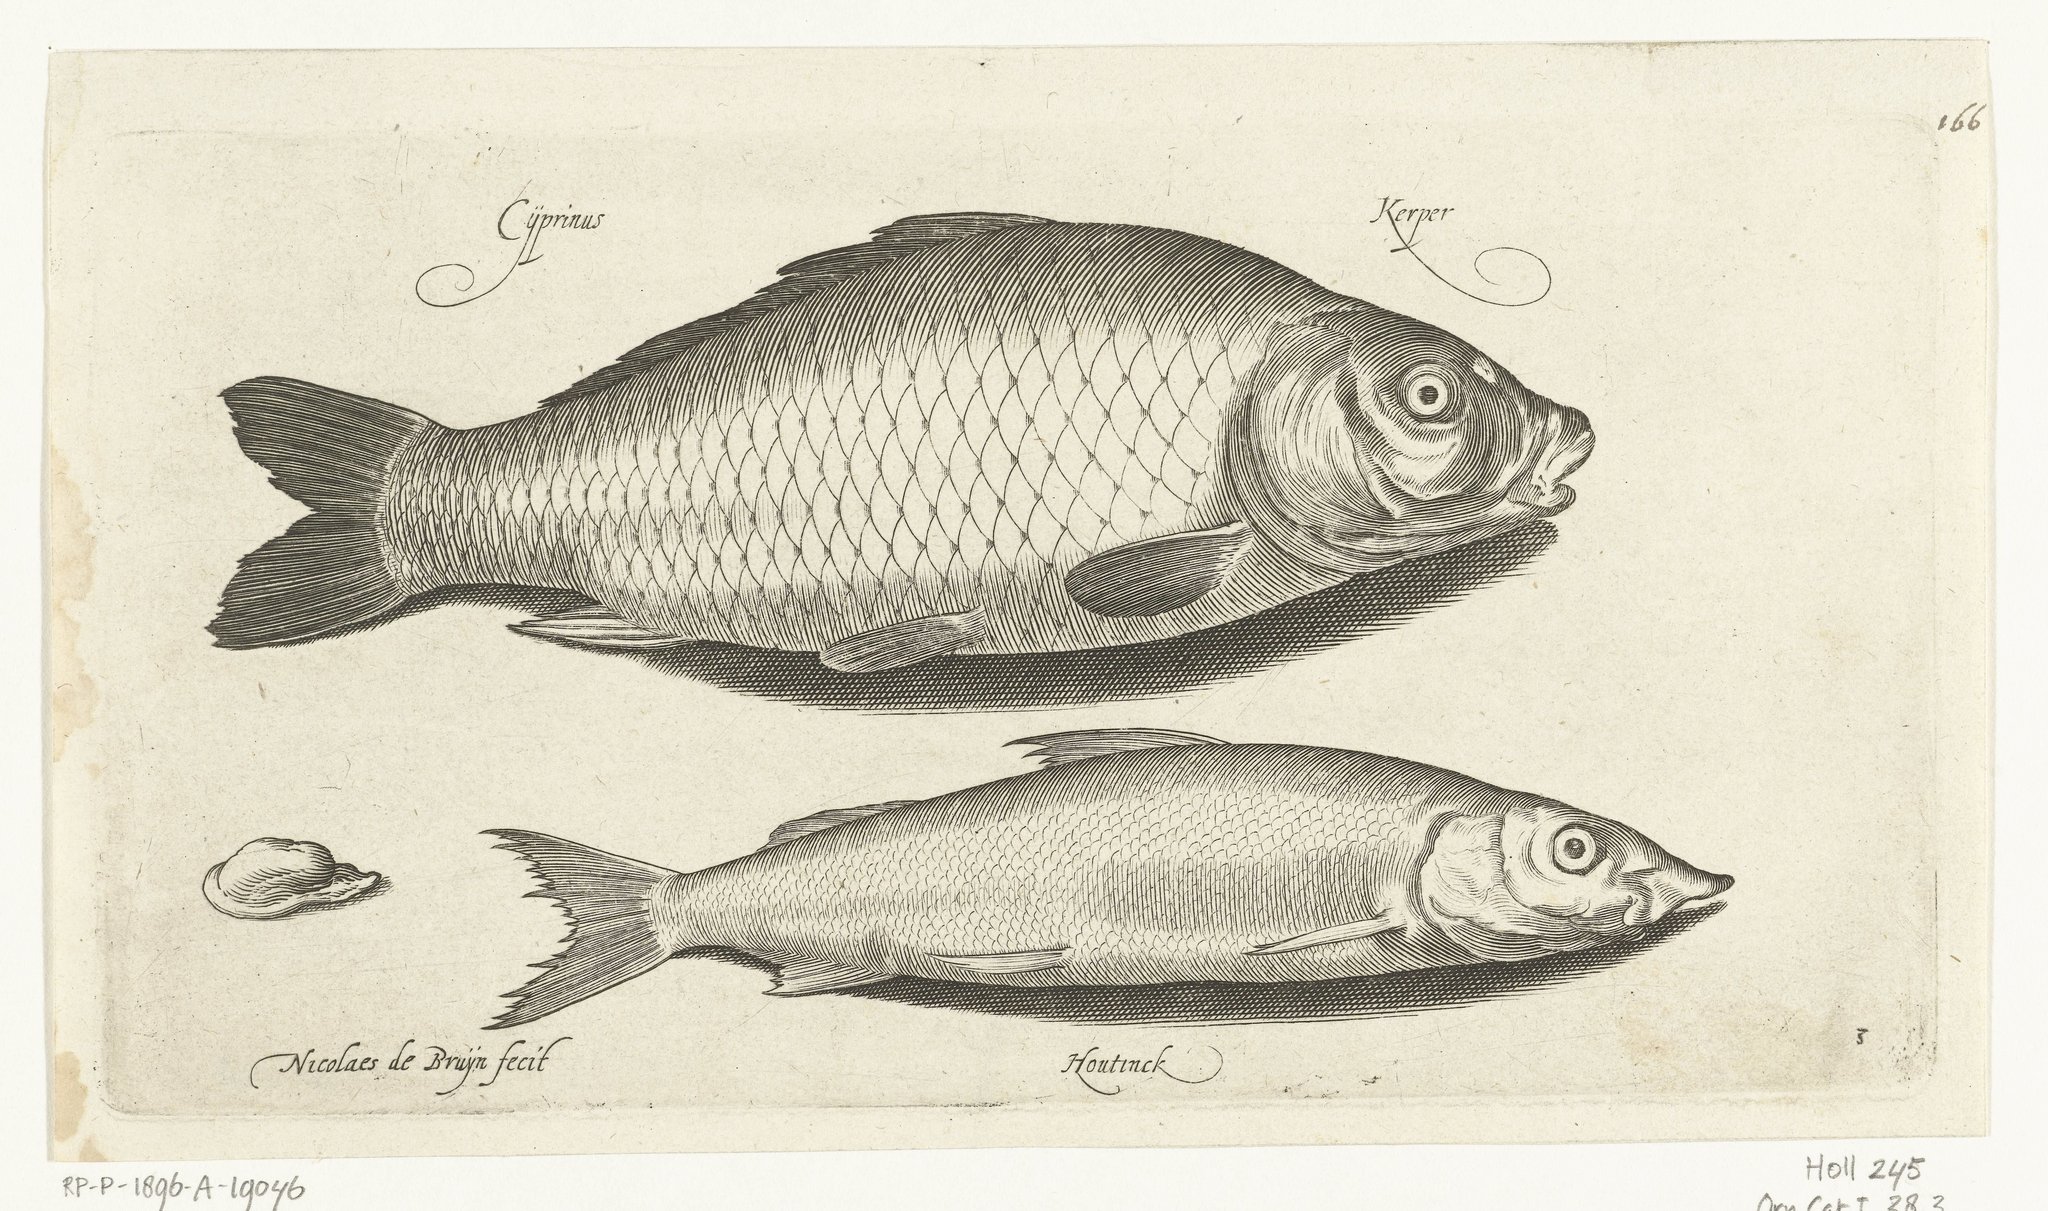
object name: print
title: Zoetwatervissen, zeevissen, kikkers, schaaldieren en zeewezens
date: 1581-1656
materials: paper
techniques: engraving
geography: netherlands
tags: fishes, bony fishes: carp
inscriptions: collector's mark: Lugt 2228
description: Prent uit serie Libelivs varia Genera piscium complectens van dertien prenten met zoetwatervissen, zeevissen, kikkers, schaaldieren en zeewezens (inclusief titelprent). Vermoedelijk ging een uitgave van Assuerus van Londerseel vooraf aan deze editie van Francoys van Beusekom, zie De Groot 1988, p. 38.